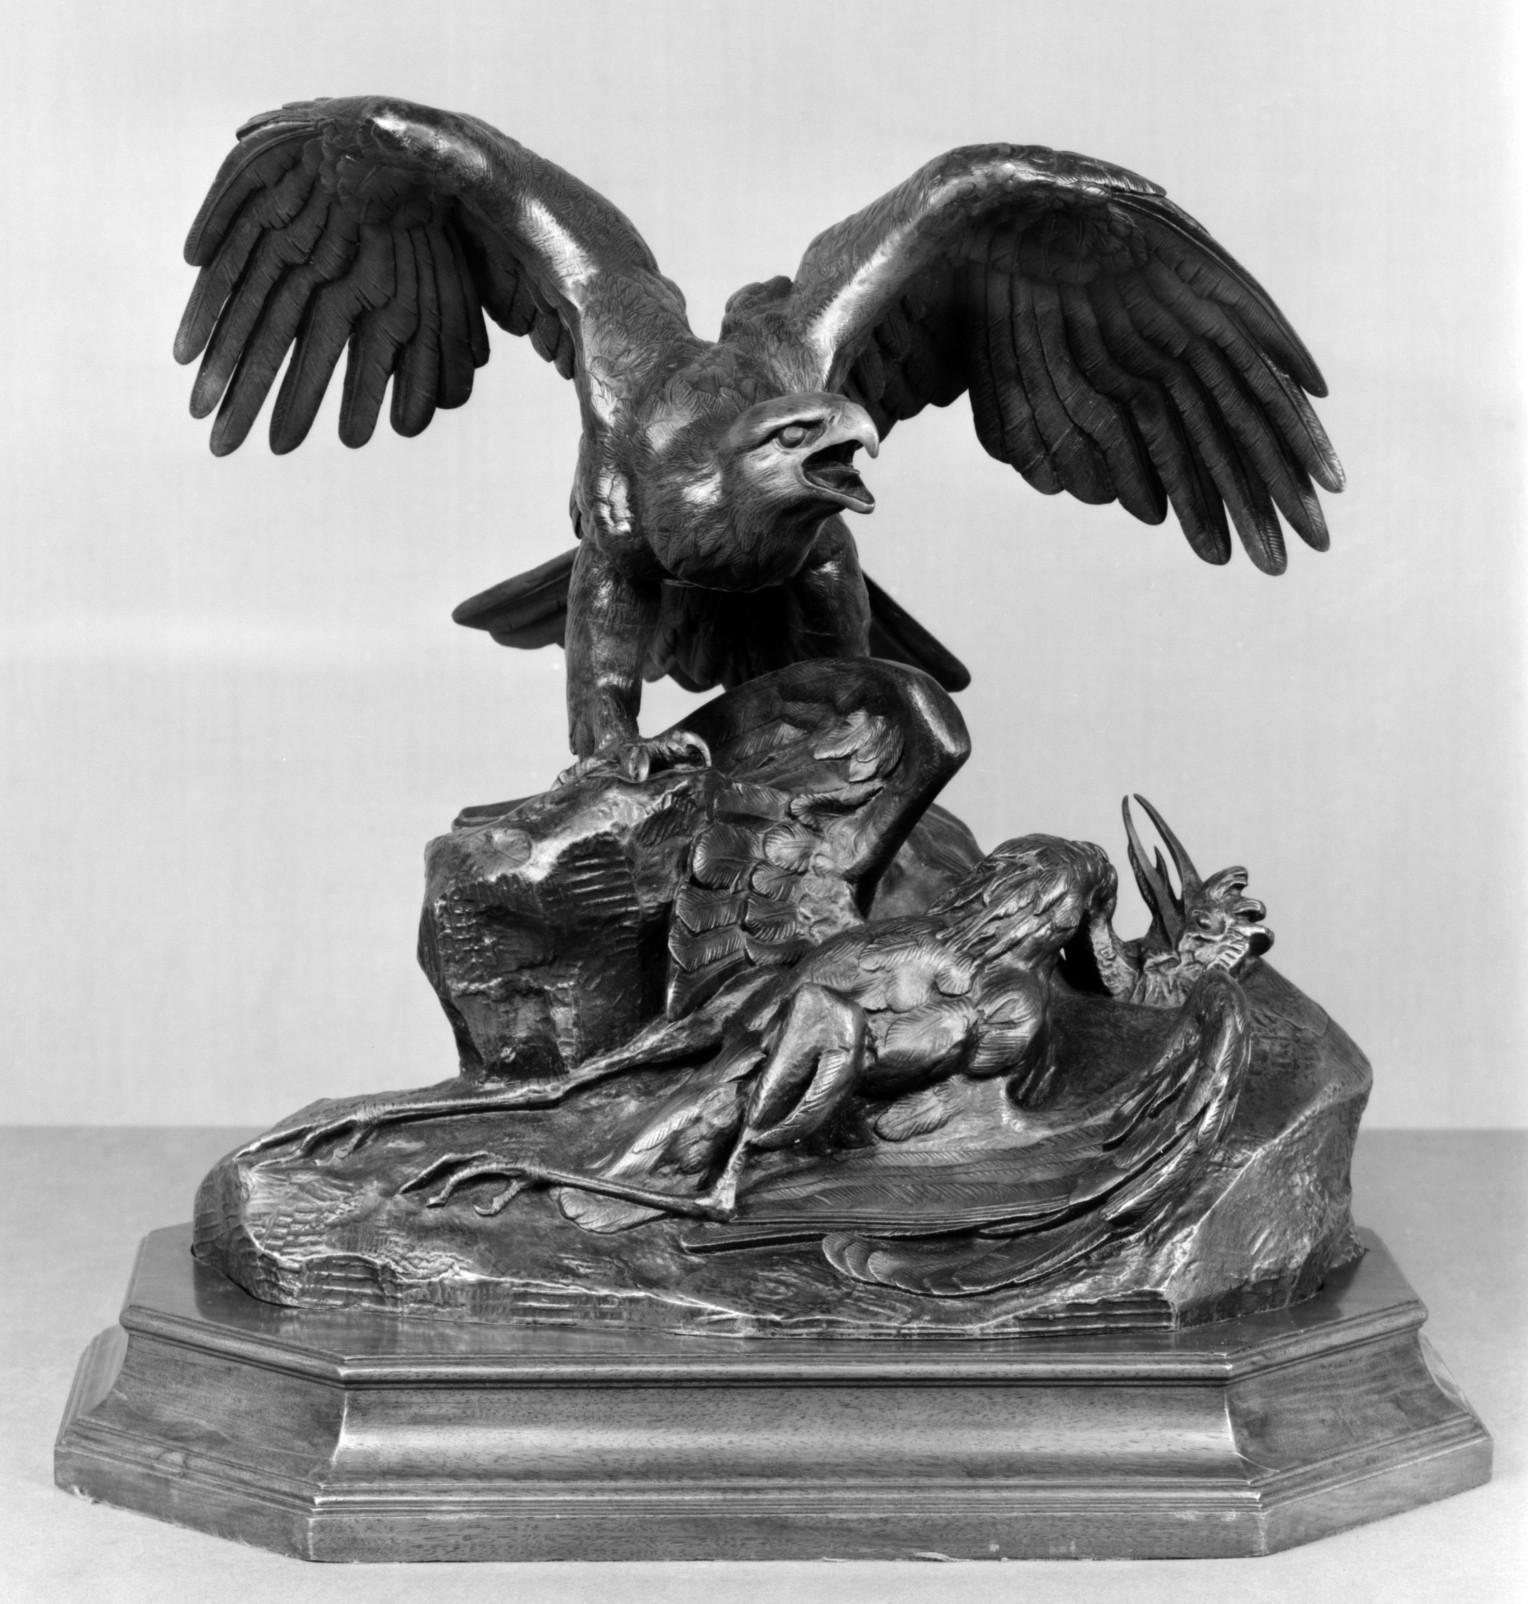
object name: statuette group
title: Eagle with a Dead Heron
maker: antoine-louis barye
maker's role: artist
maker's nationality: french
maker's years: 1795-1875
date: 1801-1900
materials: bronze, patina, wood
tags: birds,eagles